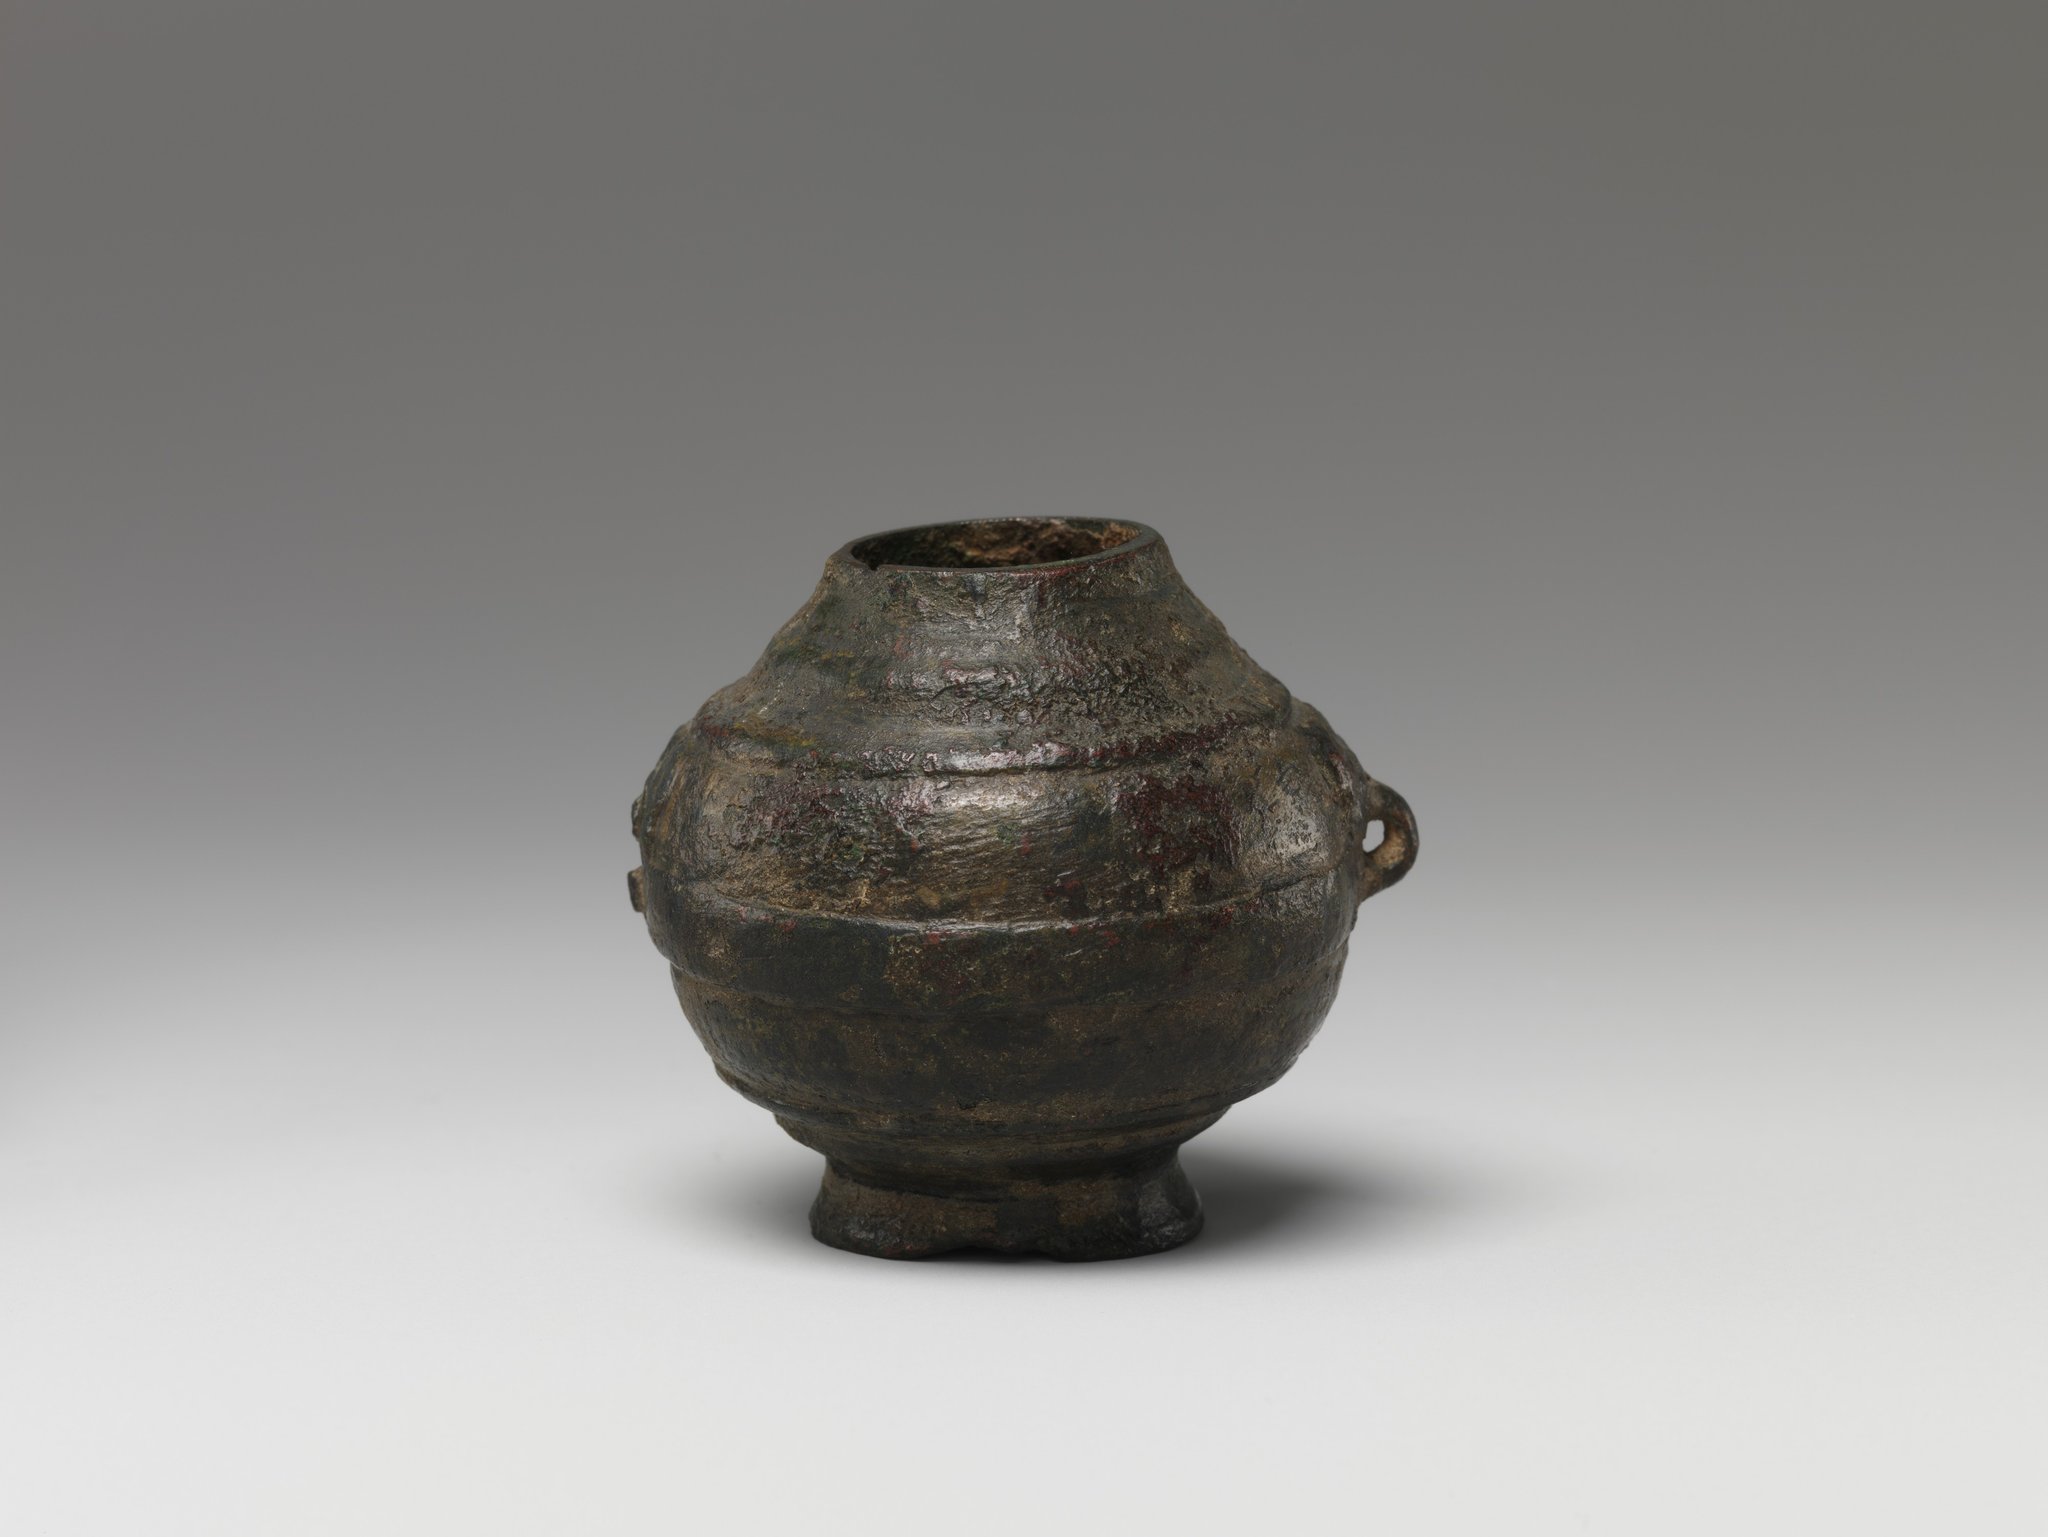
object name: jar, wine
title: Wine Jar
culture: chinese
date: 206 BCE-220 CE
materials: bronze